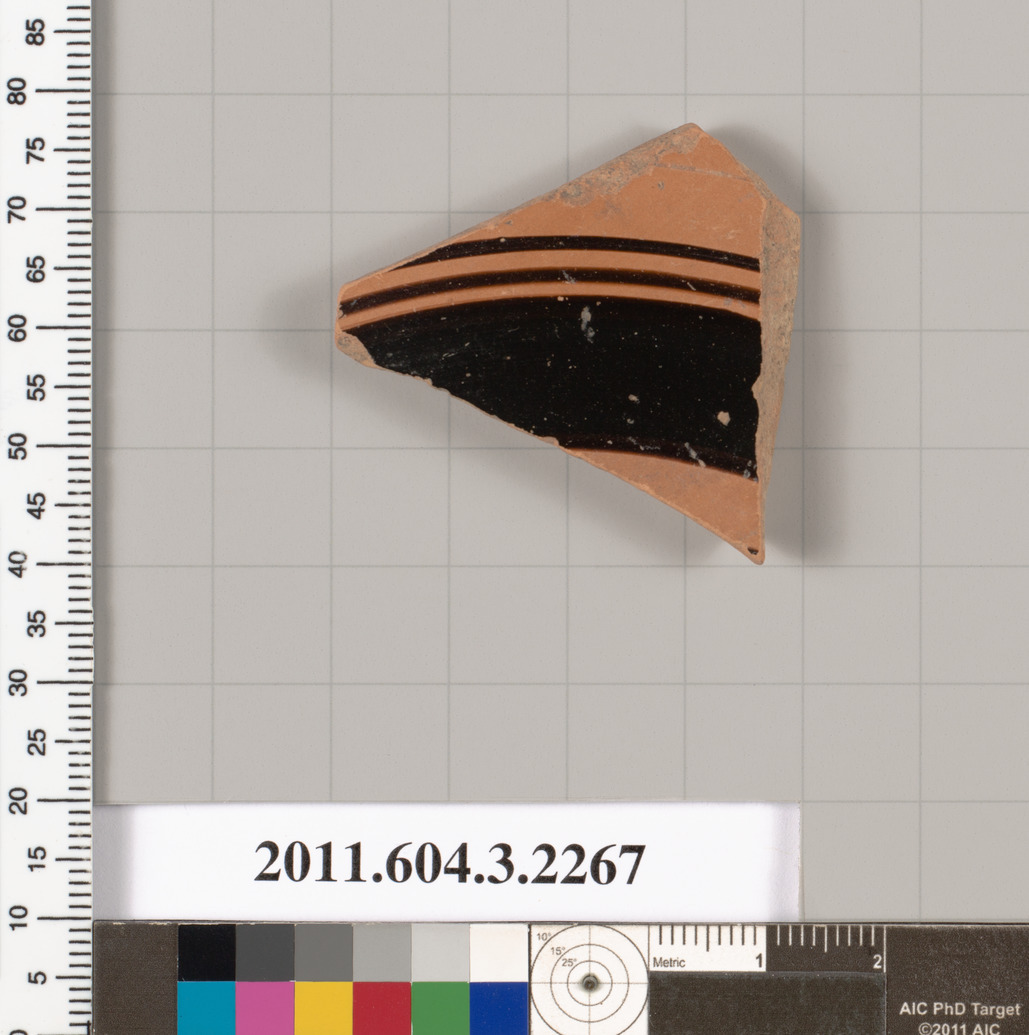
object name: kylix fragment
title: Terracotta fragment of a kylix (drinking cup)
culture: greek, attic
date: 600-401 BCE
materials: terracotta